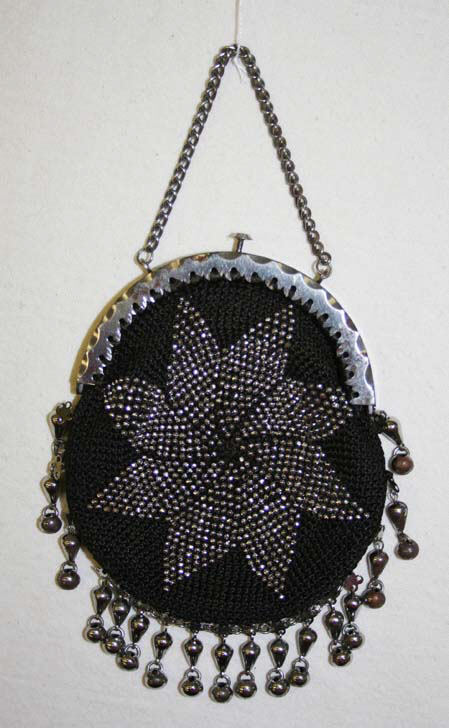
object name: purse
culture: american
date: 1860-1869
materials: silk